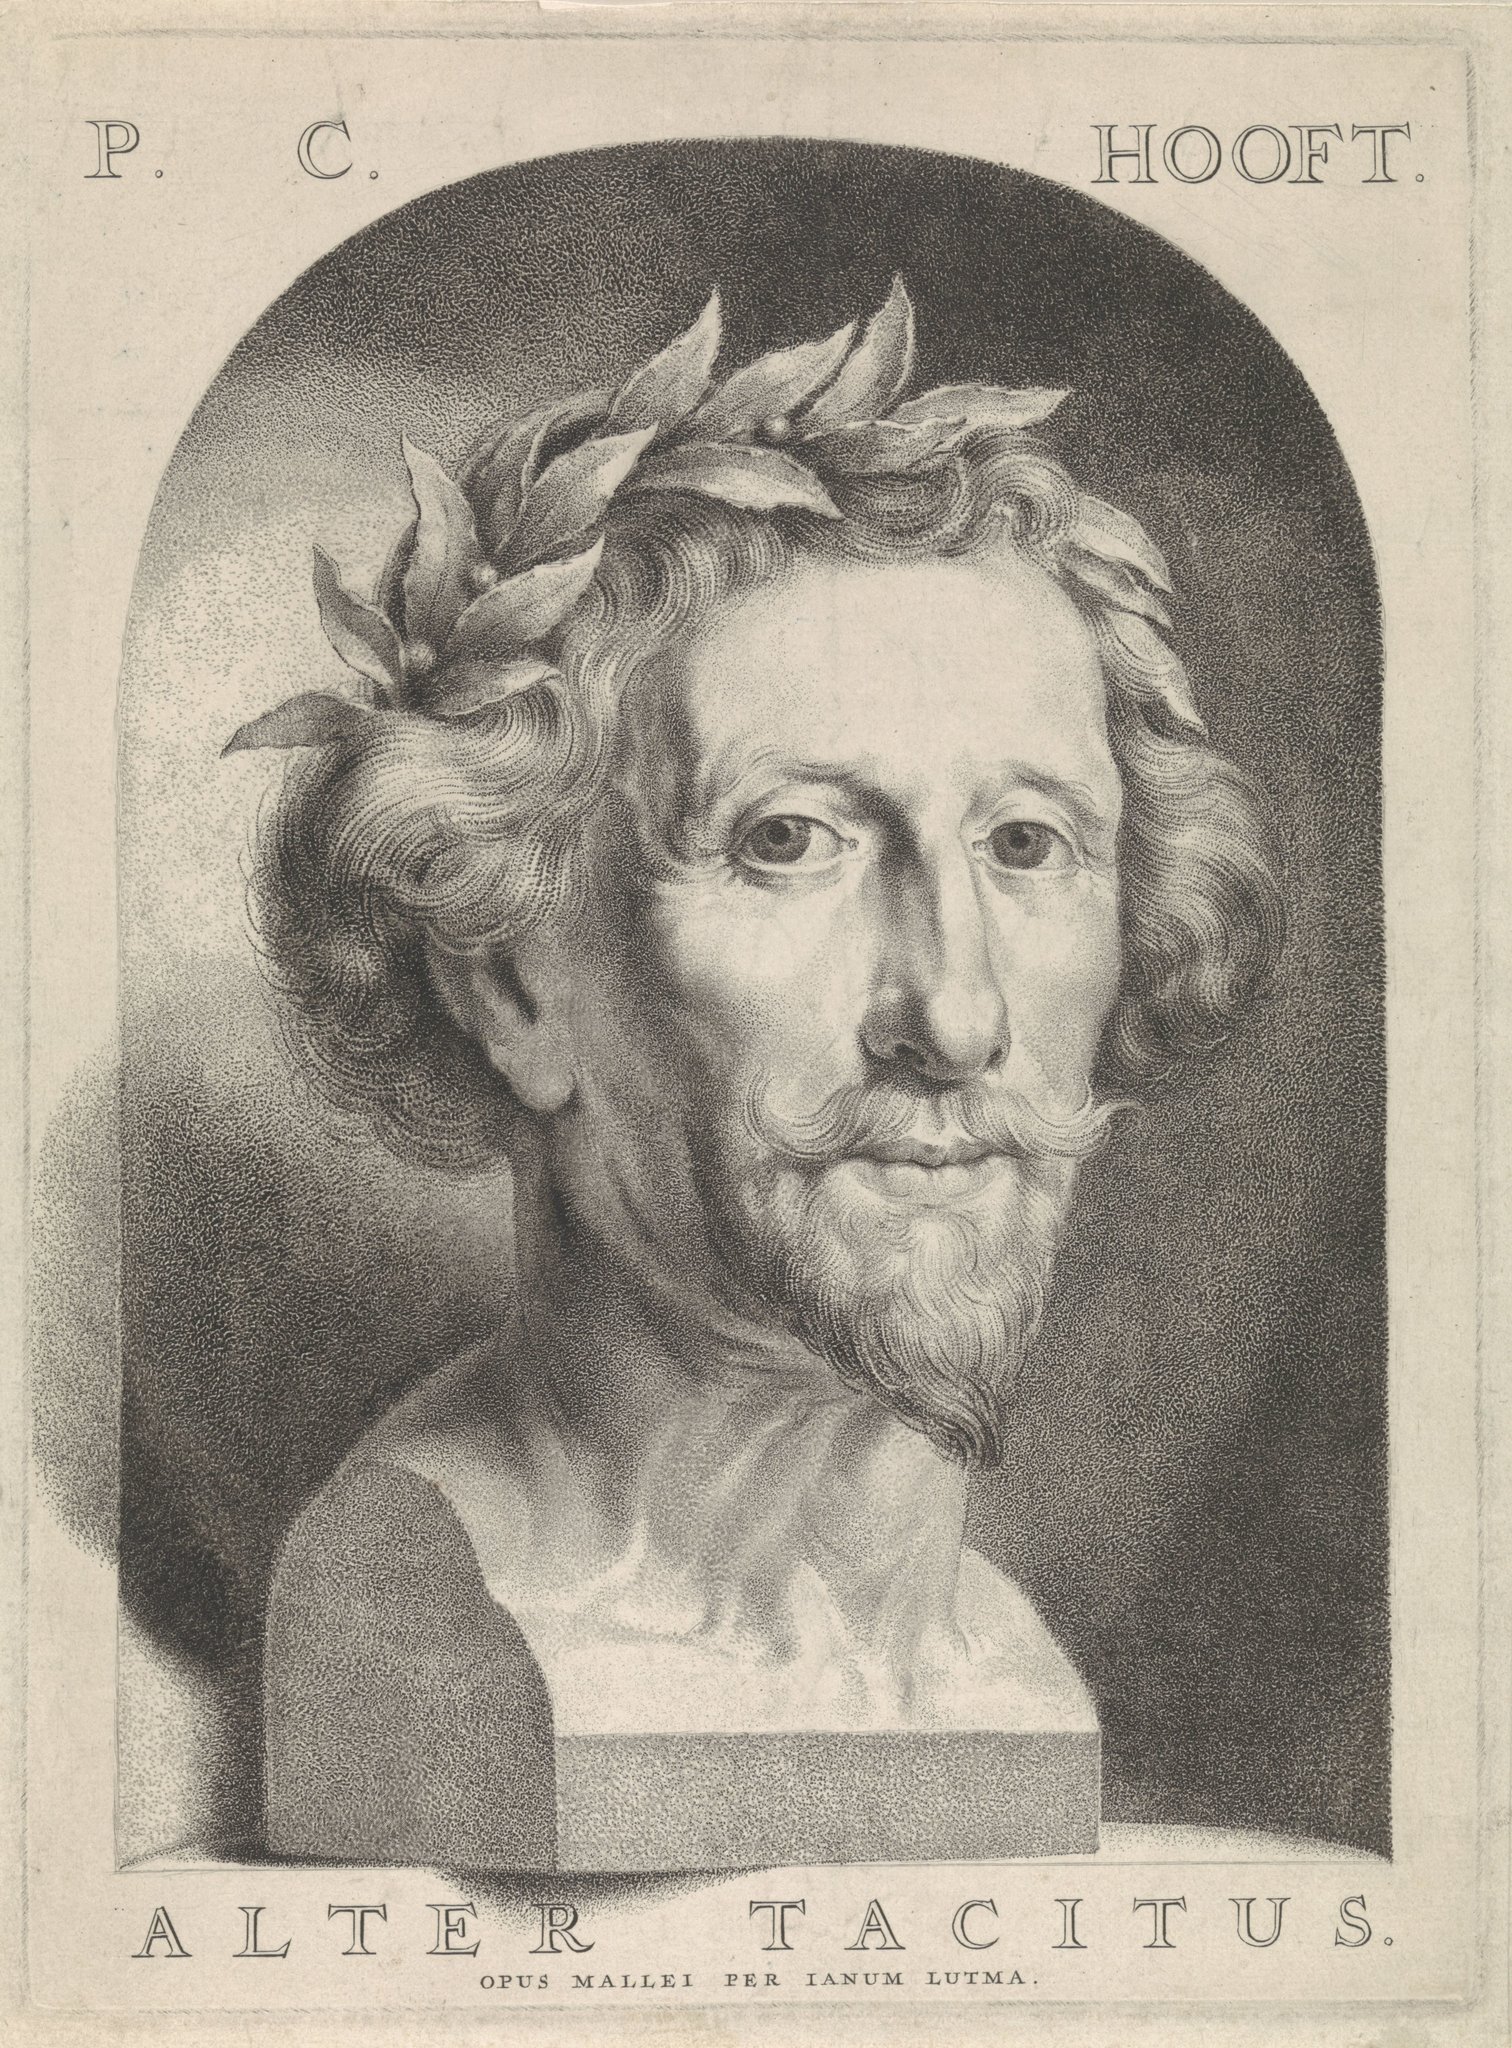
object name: print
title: Portretbuste van de dichter Pieter Corneliszoon Hooft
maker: johannes lutma (1624-1689)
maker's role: print maker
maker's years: 1624-1689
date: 1634-1689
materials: paper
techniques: engraving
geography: amsterdam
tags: amsterdam, the hague, pieter corneliszoon hooft, piece of sculpture, reproduction of a piece of sculpture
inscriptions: collector's mark: Lugt 2228